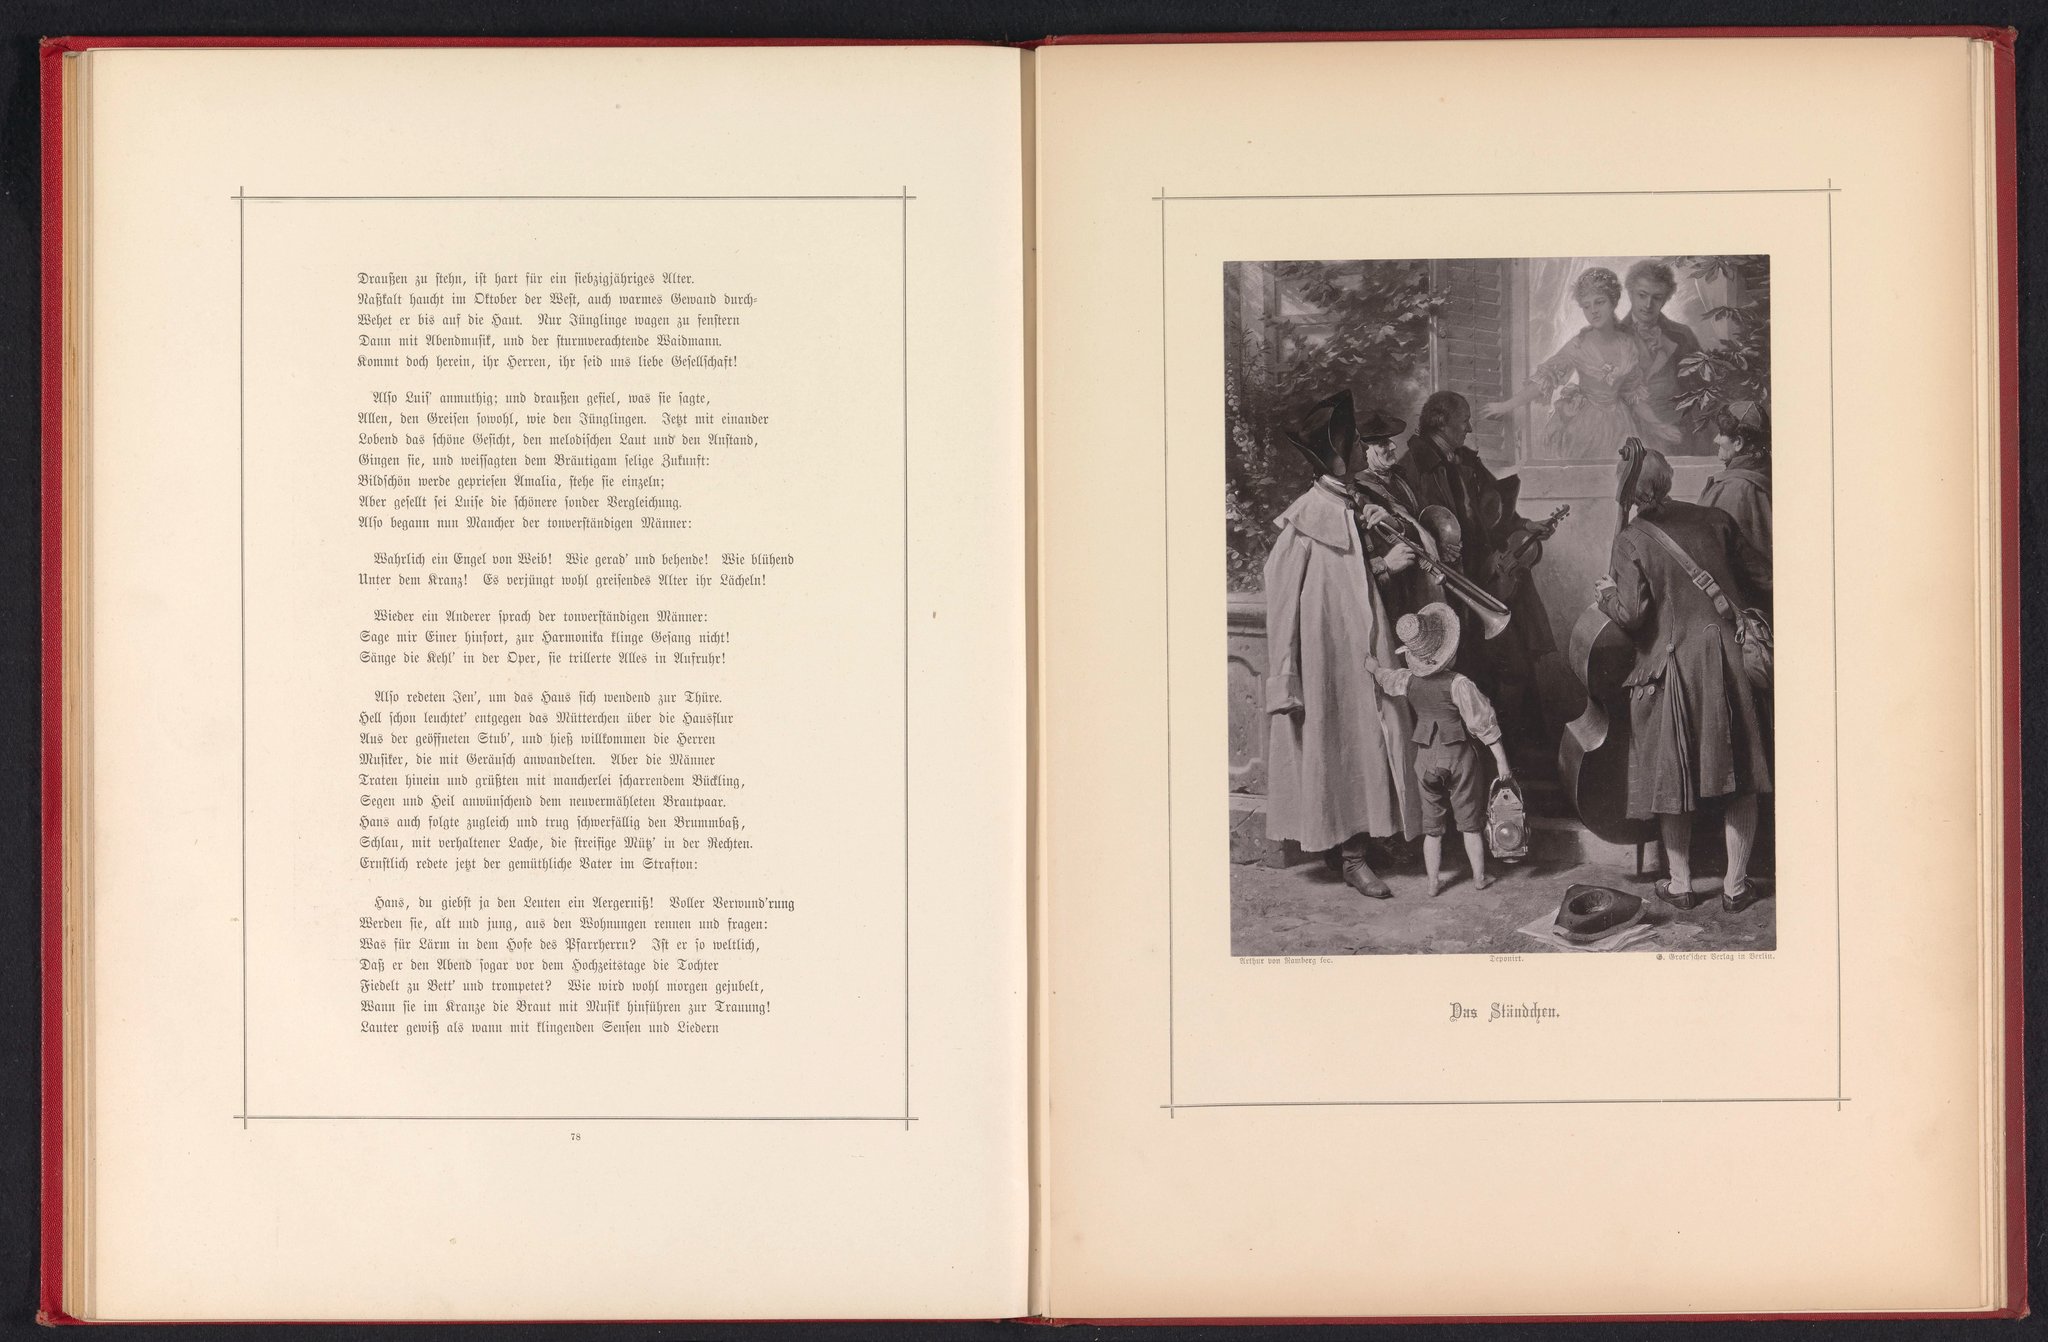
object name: photomechanical print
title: Das Ständchen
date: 1874-1884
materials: paper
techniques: photograph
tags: musician - cc - out of doors, opening the window